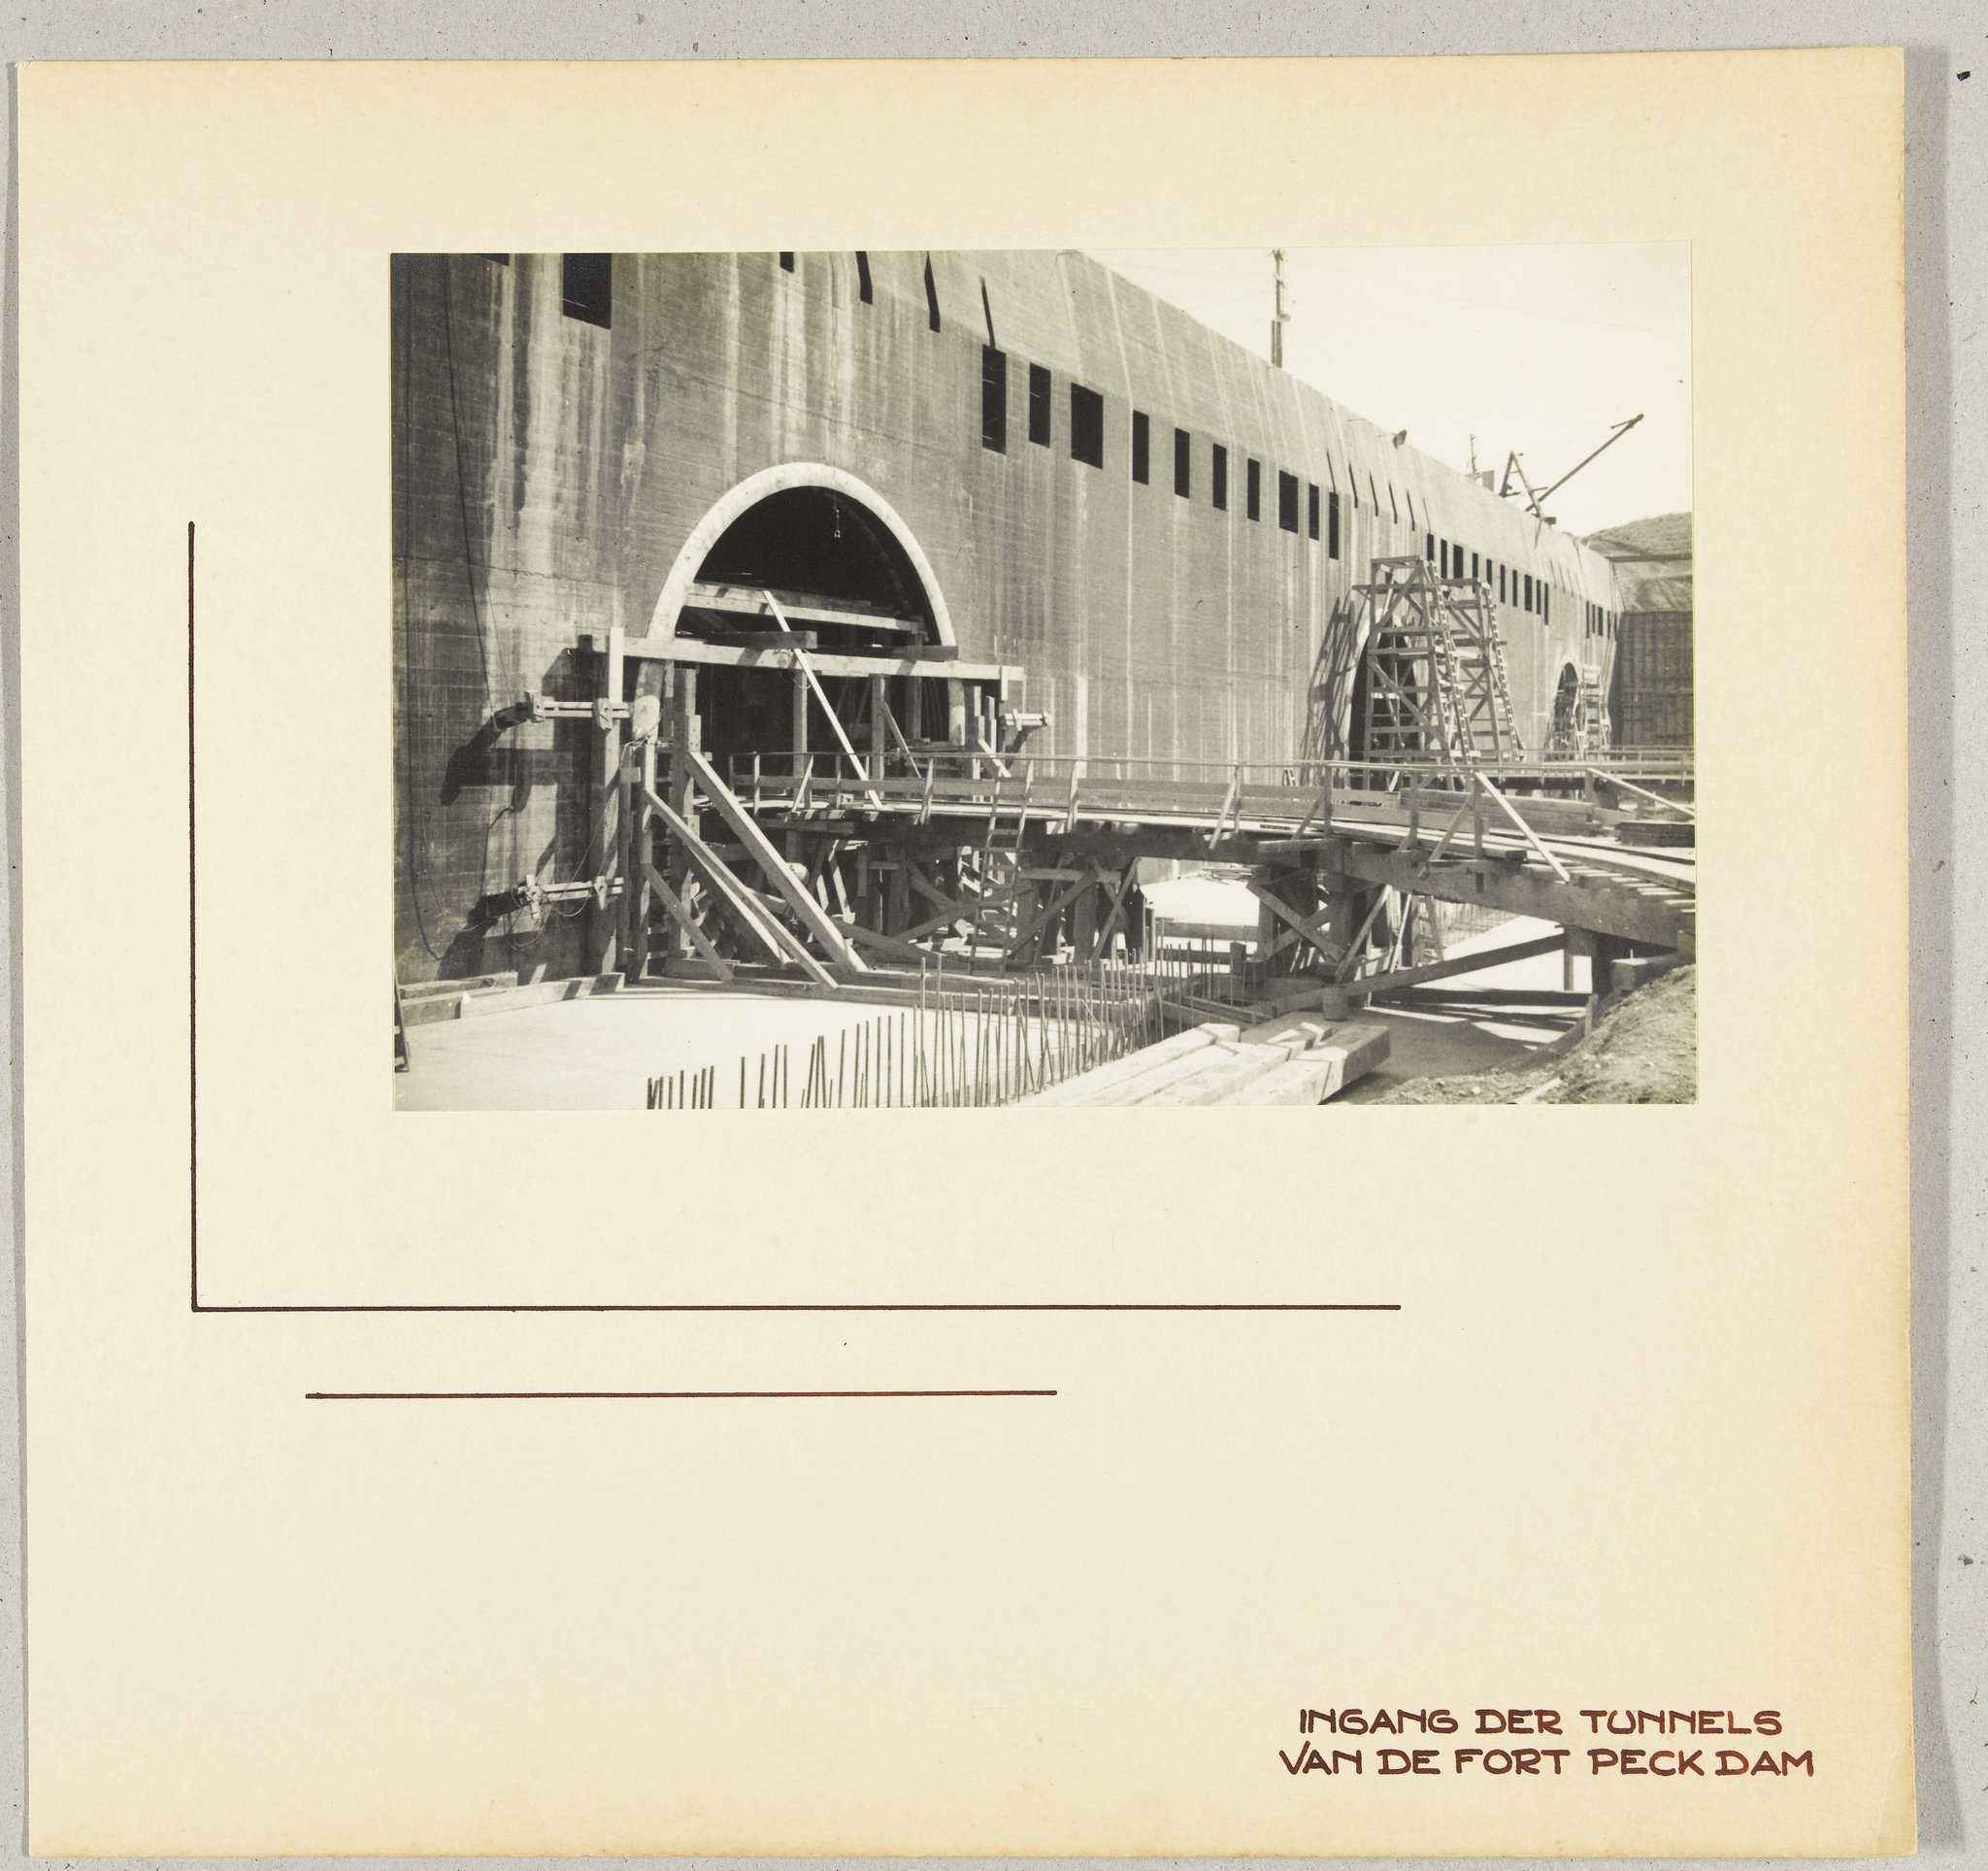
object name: photograph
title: Ingang der tunnels van de Fort Peck dam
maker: wouter cool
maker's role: engineer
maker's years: 1877-1947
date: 1936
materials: cardboard, paper, photographic support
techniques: gelatin silver print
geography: united states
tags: dam (in canal)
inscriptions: title: ‘INGANG DER TUNNELS / VAN DE FORT PECK DAM’